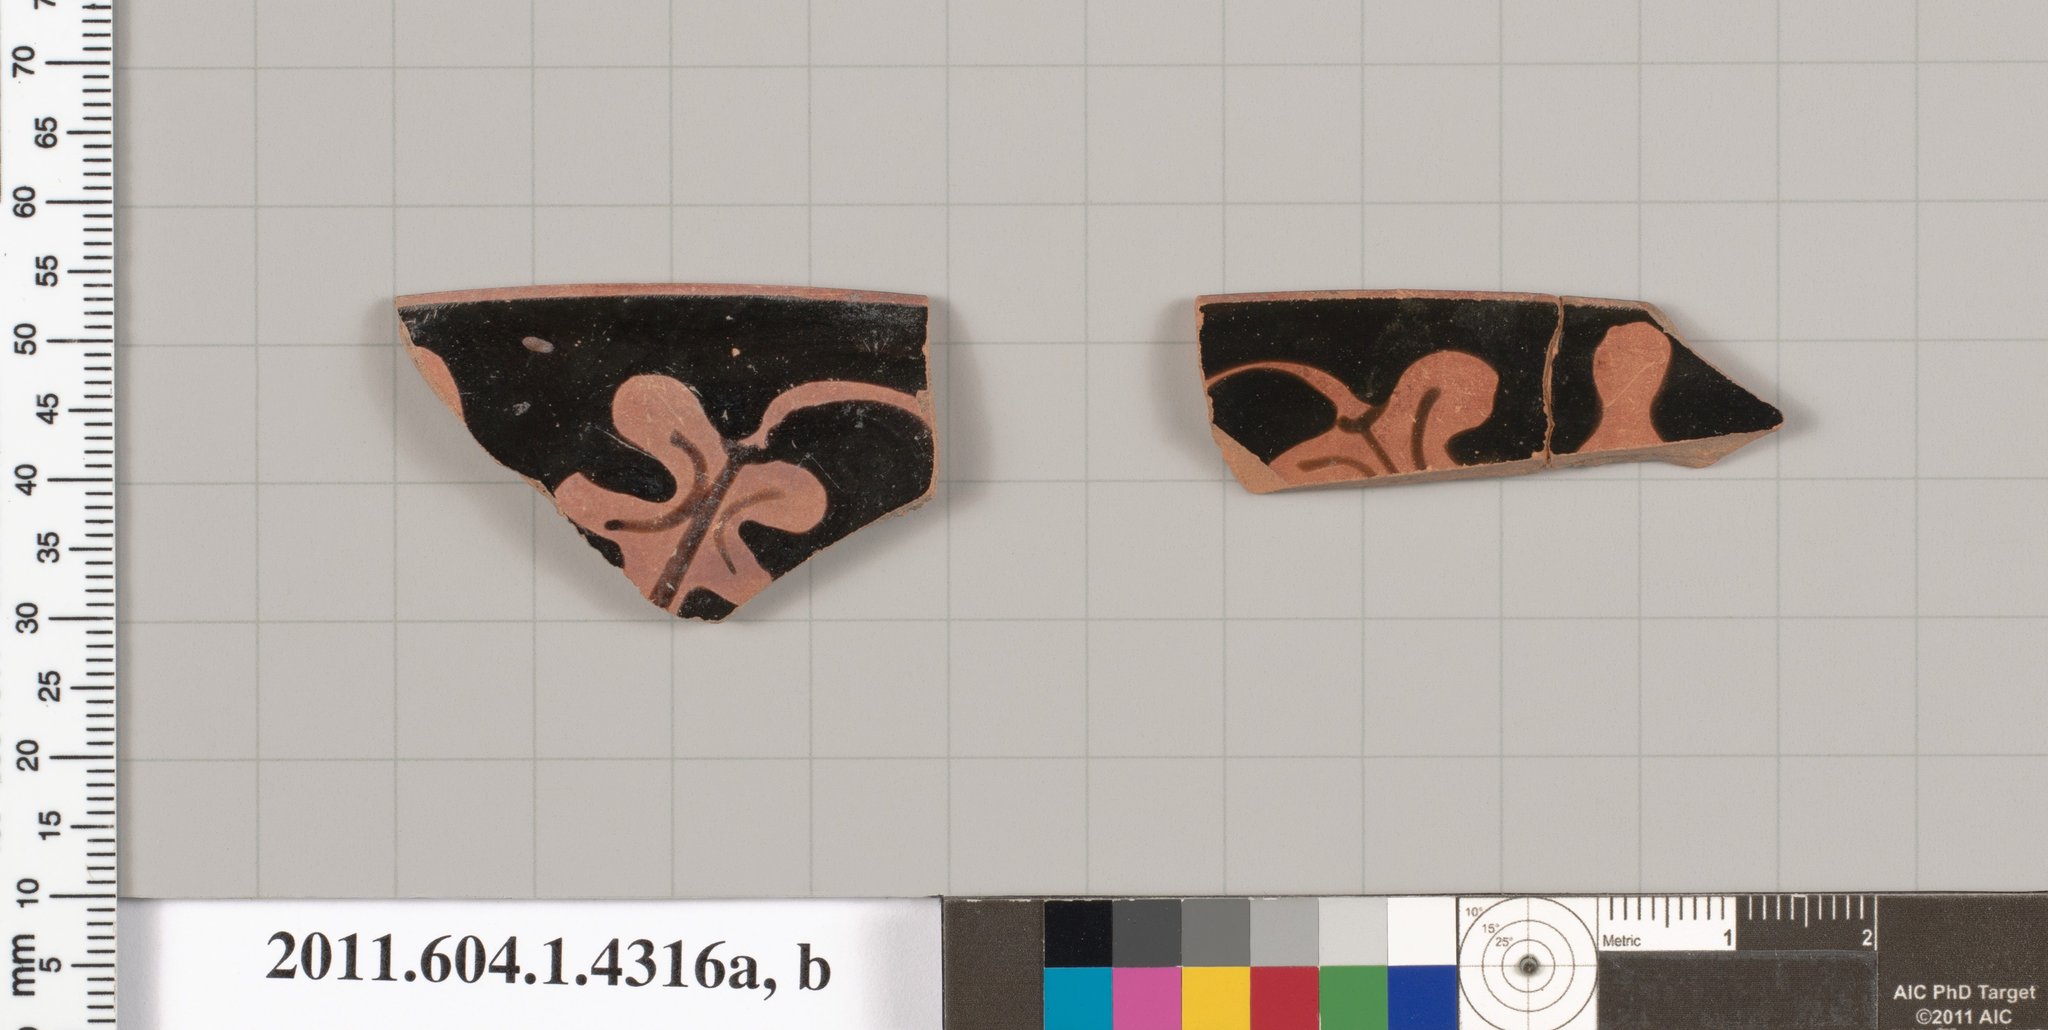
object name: kylix fragment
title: Terracotta rim fragments of kylikes (drinking cups)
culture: greek, attic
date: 500-451 BCE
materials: terracotta